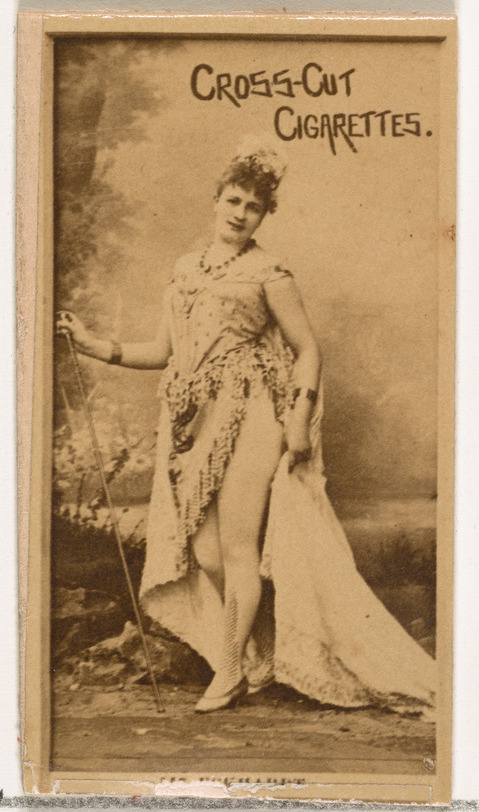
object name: print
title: Unknown Actress, from the Actors and Actresses series (N145-2) issued by Duke Sons & Co. to promote Cross Cut Cigarettes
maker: w. duke, sons & co.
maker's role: publisher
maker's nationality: american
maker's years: 1870-1920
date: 1880-1889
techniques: albumen silver print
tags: portraits,women,actresses